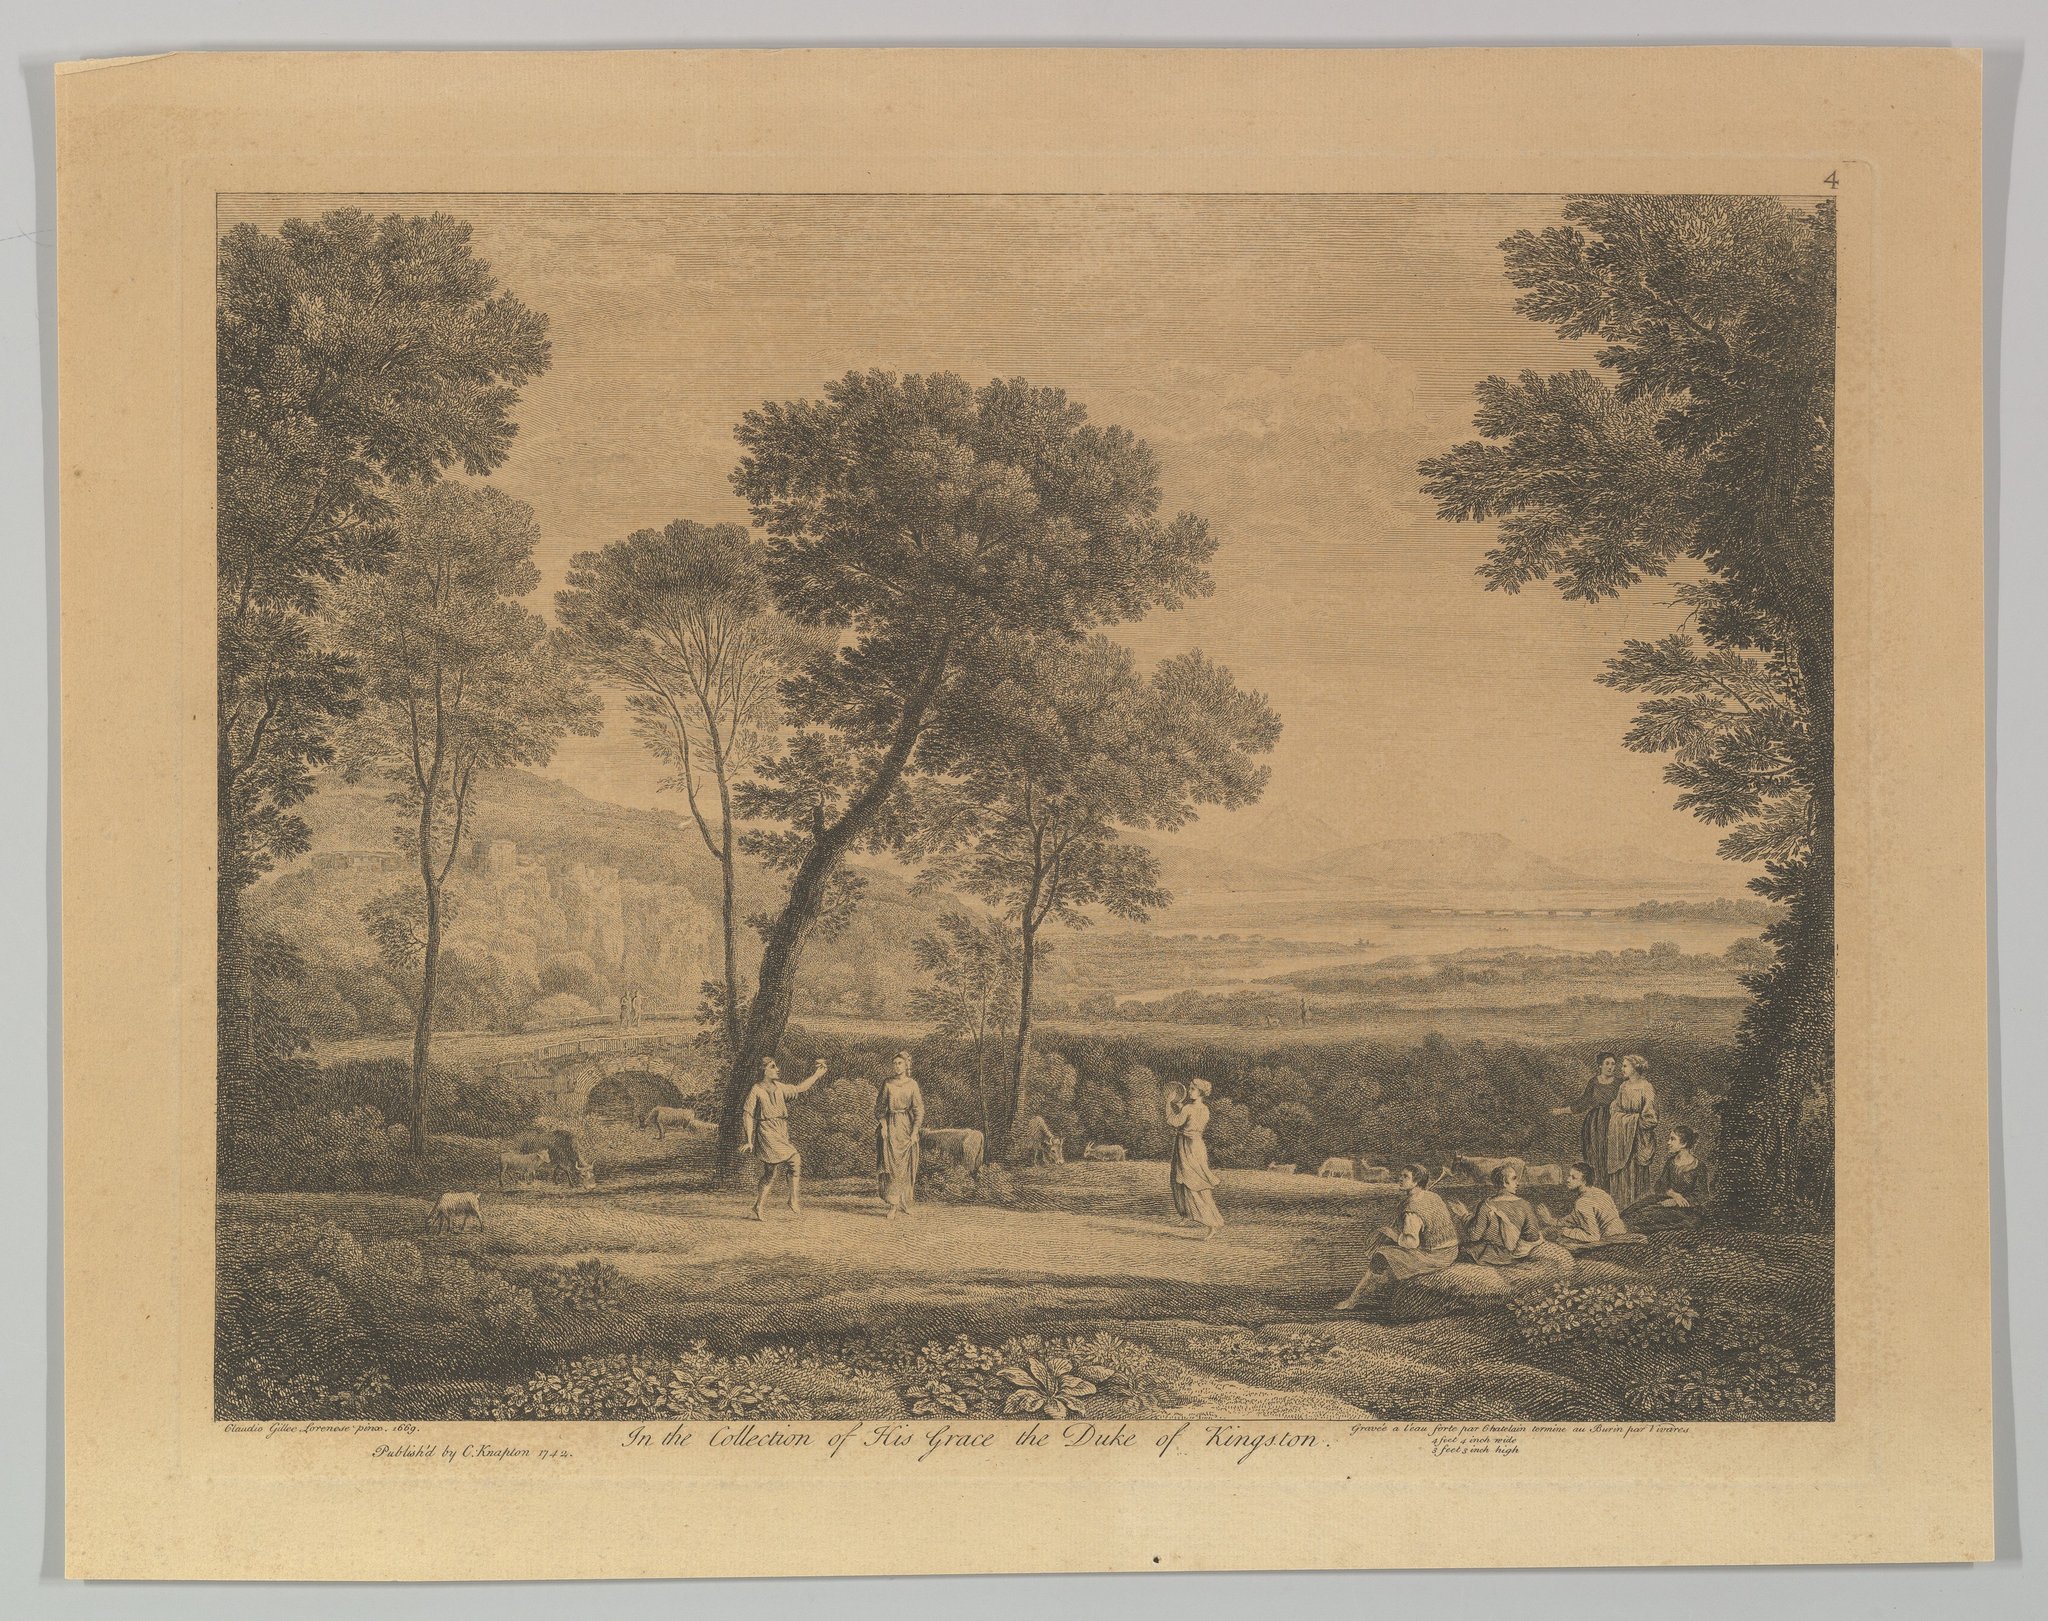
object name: print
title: Dance Under the Trees (Landscape with Rural Dance)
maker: claude lorrain (claude gellée)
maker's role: artist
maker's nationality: french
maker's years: 1604-1682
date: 1742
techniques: engraving, etching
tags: animals,men,women,dancing,trees